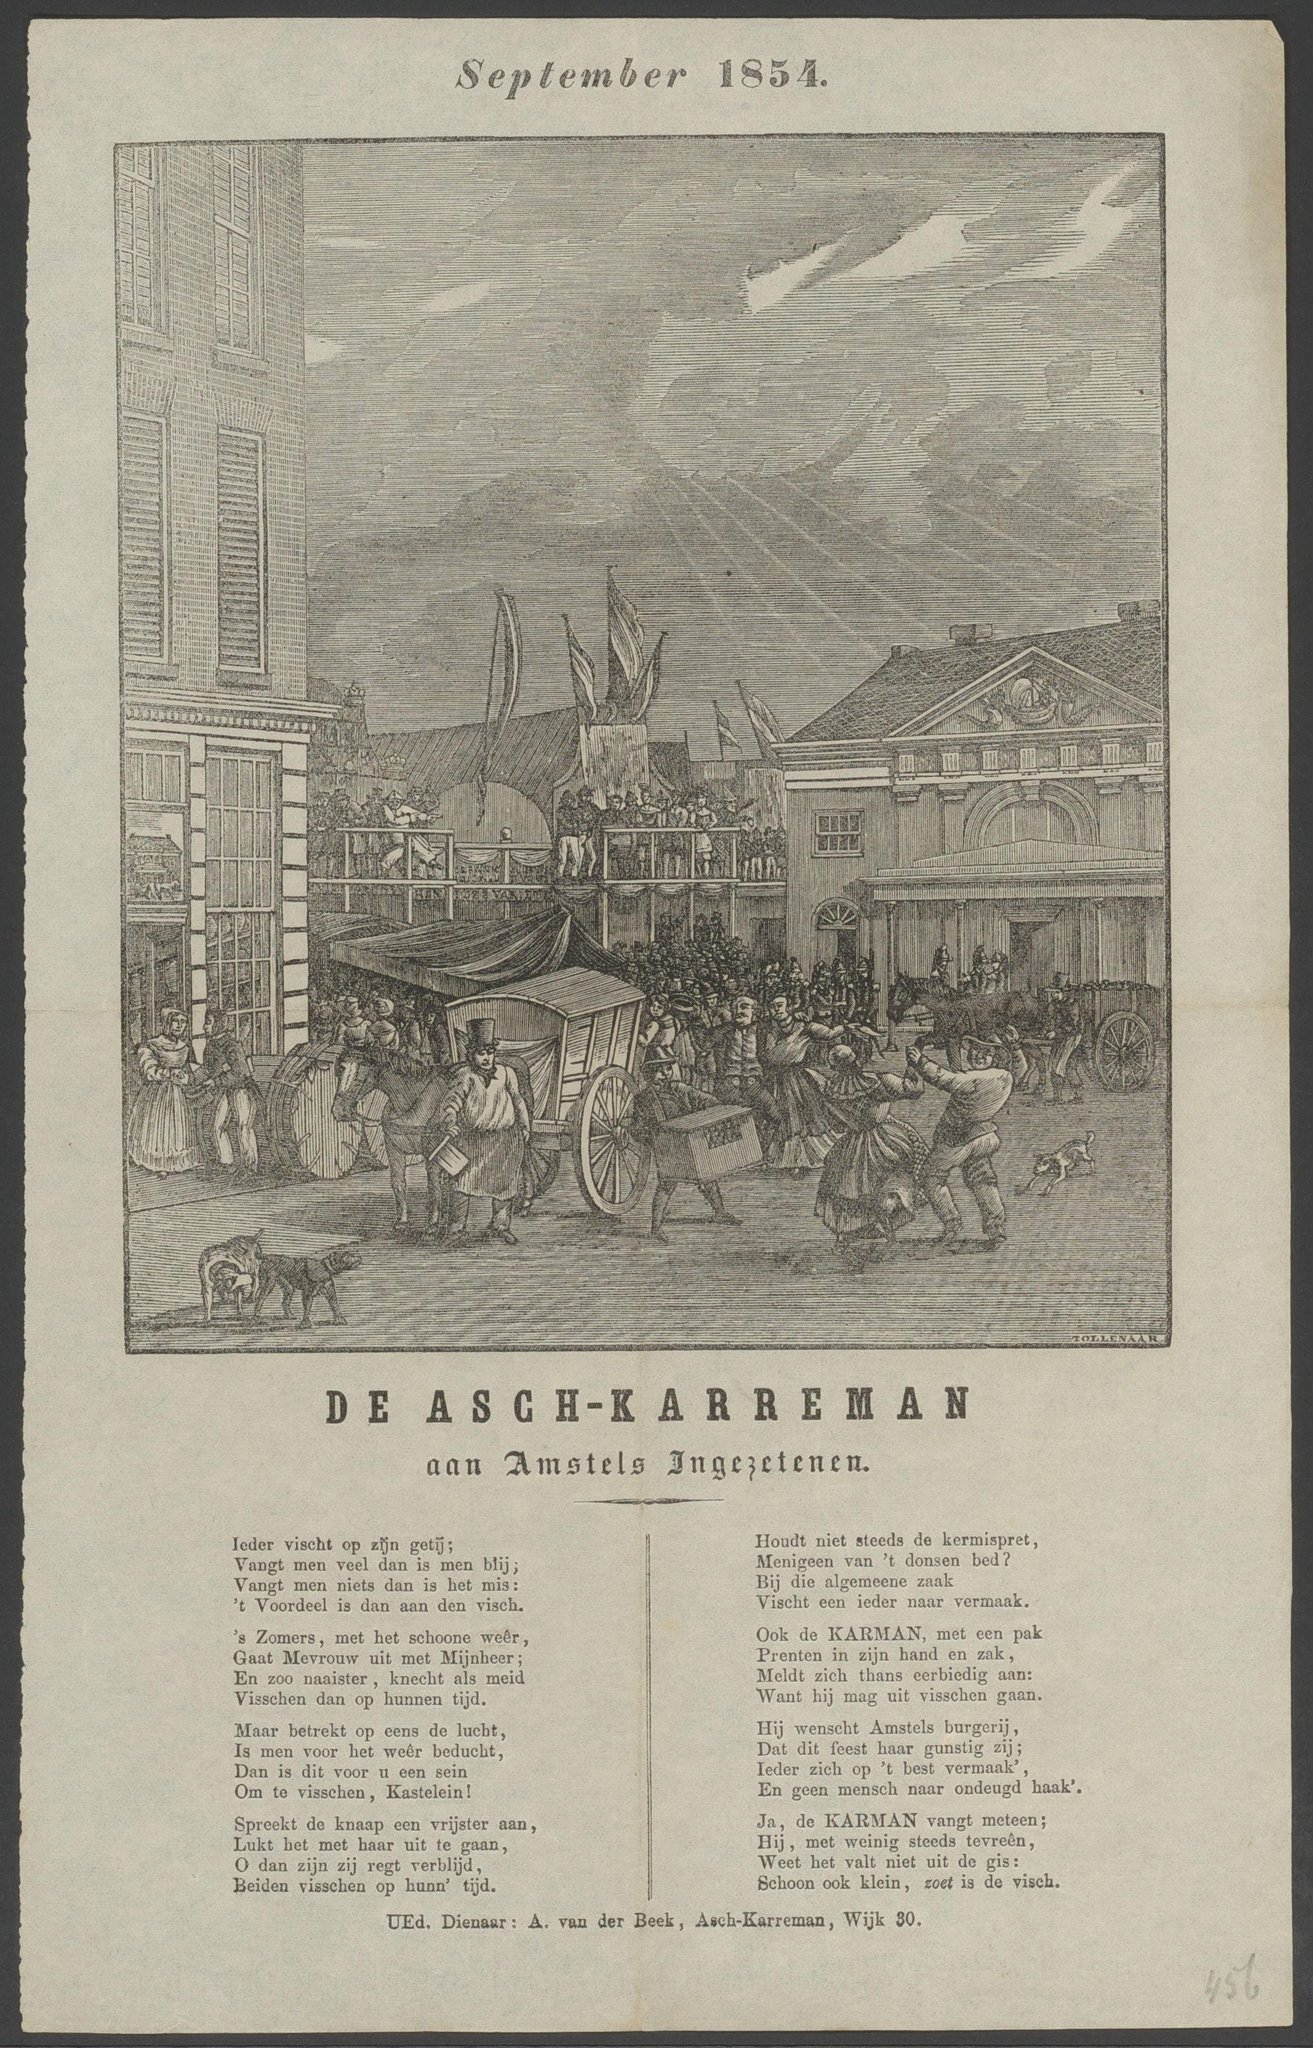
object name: fair print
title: Kermisprent van de Amsterdamse askarrenmannen voor het jaar 1854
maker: dirk wijbrand tollenaar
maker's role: print maker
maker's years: 1808-1858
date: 1854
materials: paper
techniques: letterpress printing, engraving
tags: pleasure fair and circus, garbage collection, amsterdam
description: Kermisprent namens de askarrenmannen (karrenman of vuilnisman) te Amsterdam, september 1854. Gezicht op de kermis op de Botermarkt met de Regulierswaag. Op de markt twee vuilniskarren. Onderaan een gedicht in twee kolommen. Namens A. van der Beek, de askarreman van wijk no. 30. Onderwerpsrubrieken binnen de Atlas Zeden en Gewoonten: Zeden en gewoonten in engeren zin, Volksleven, Volksbladen, Nieuwjaars- en Kerstwenschen, Amsterdam.